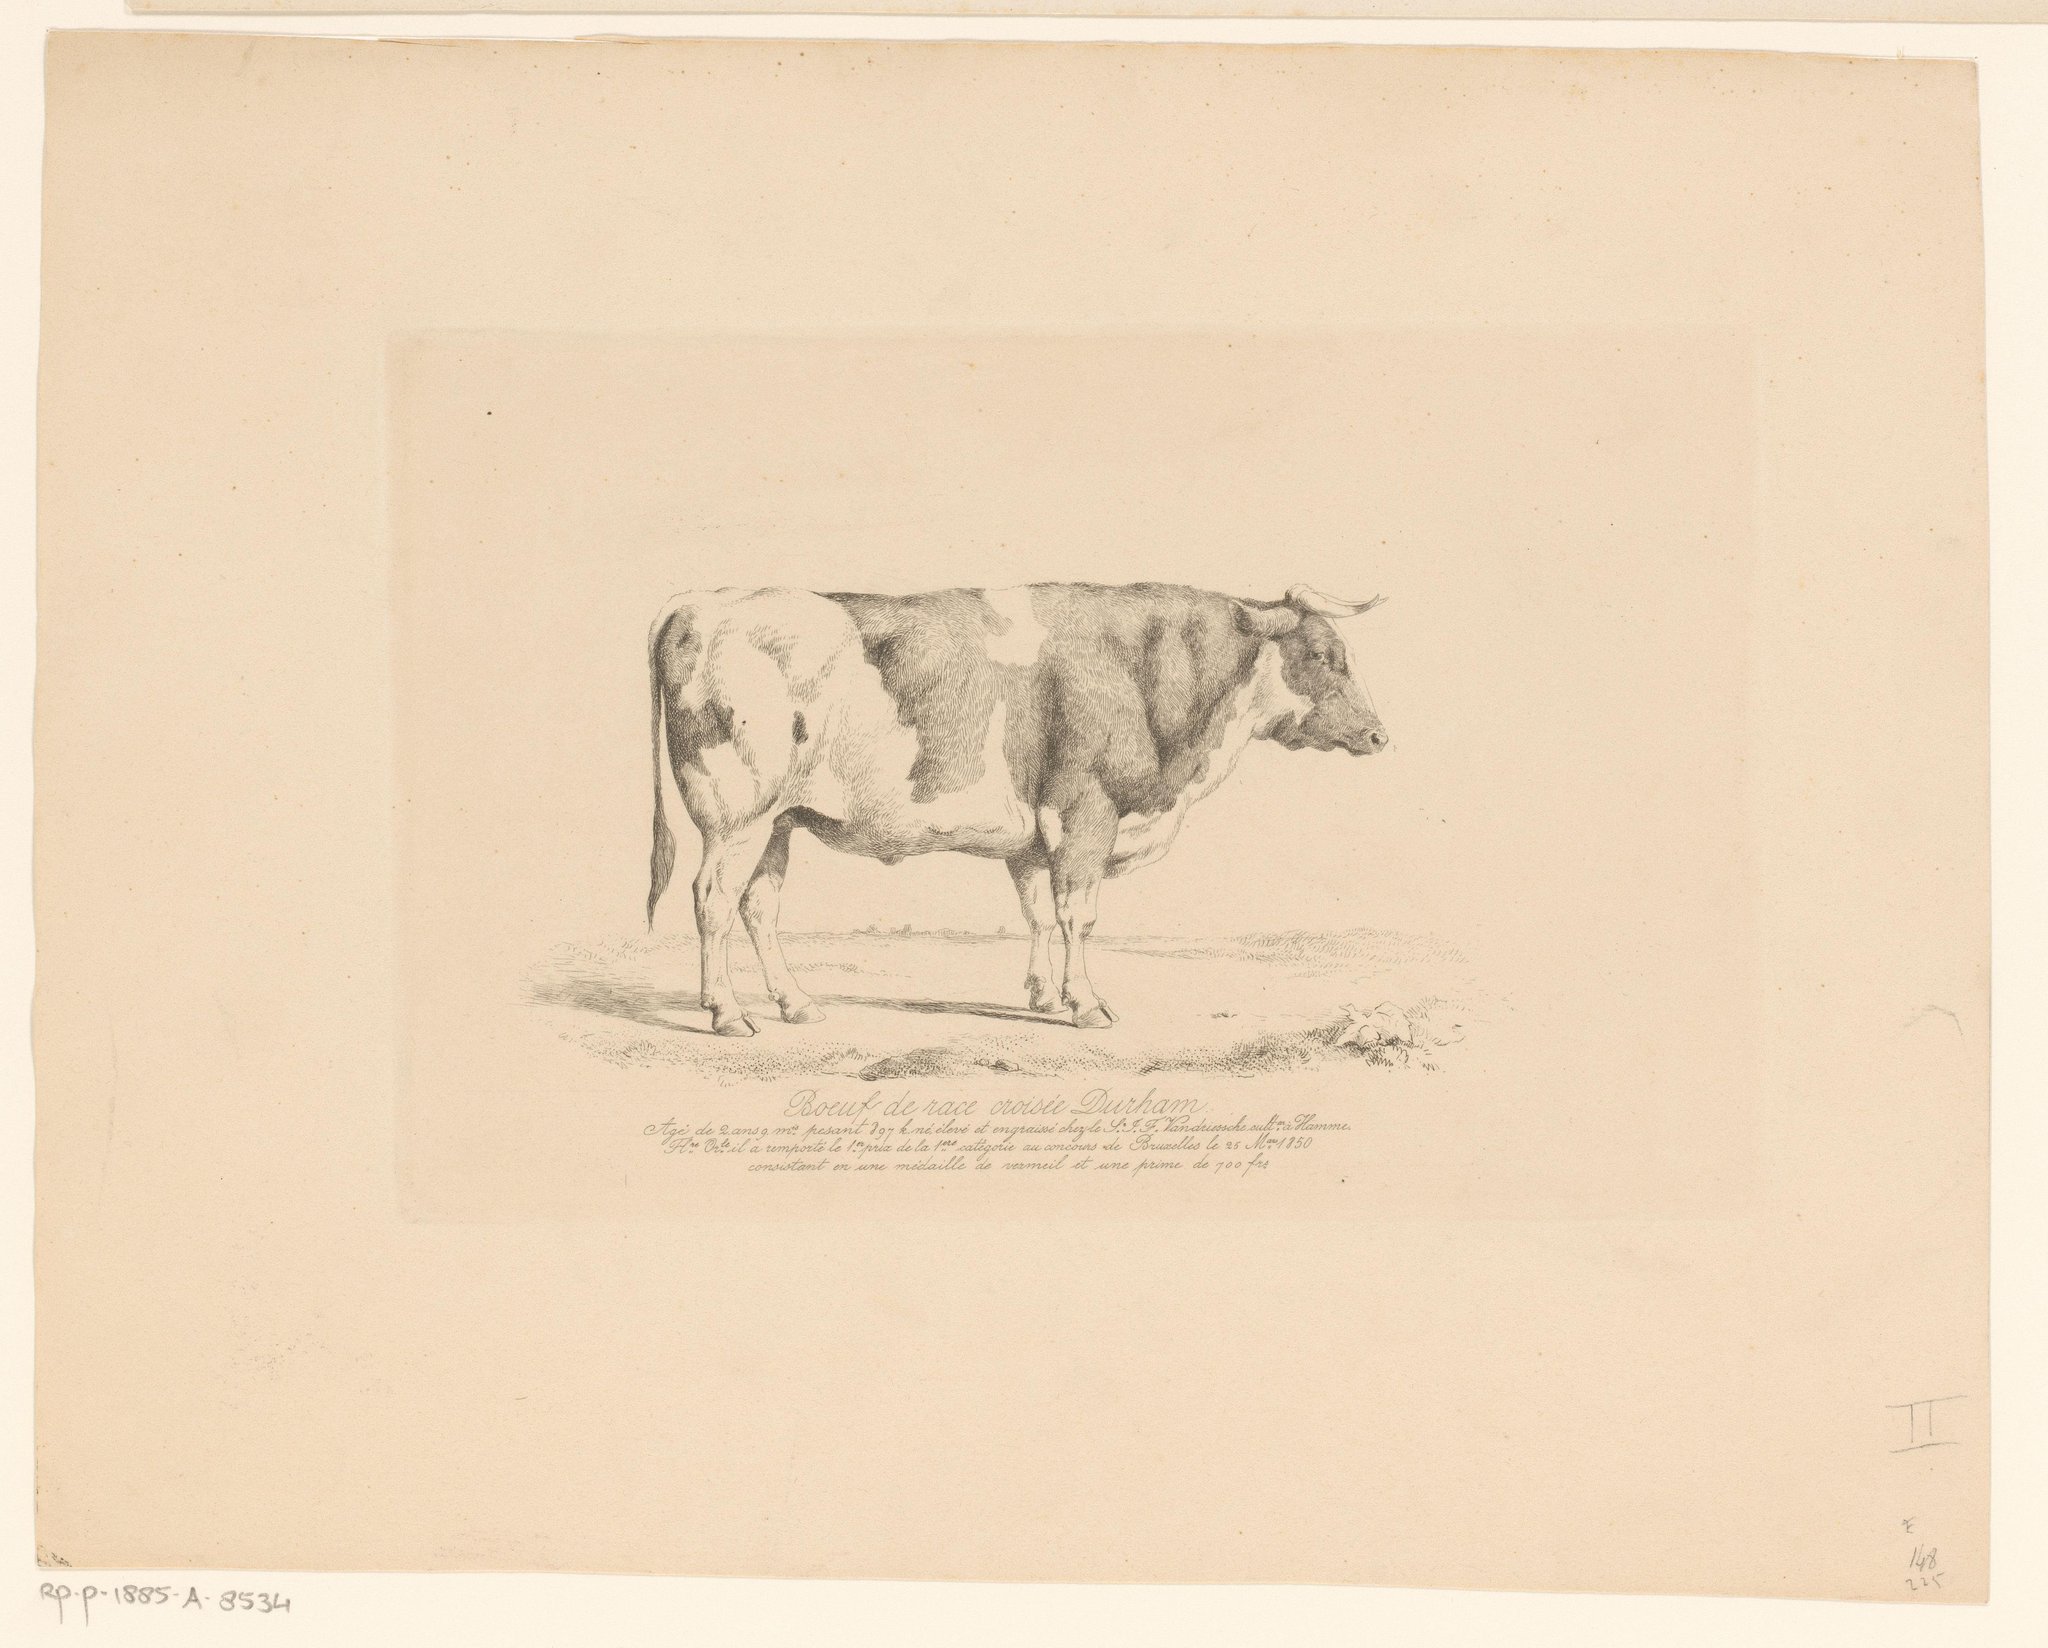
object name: print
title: Boeuf de race croisée Durham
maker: edmond tschaggeny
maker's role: print maker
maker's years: 1818-1873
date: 1850-1873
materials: paper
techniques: etching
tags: bull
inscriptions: collector's mark: Lugt 2228